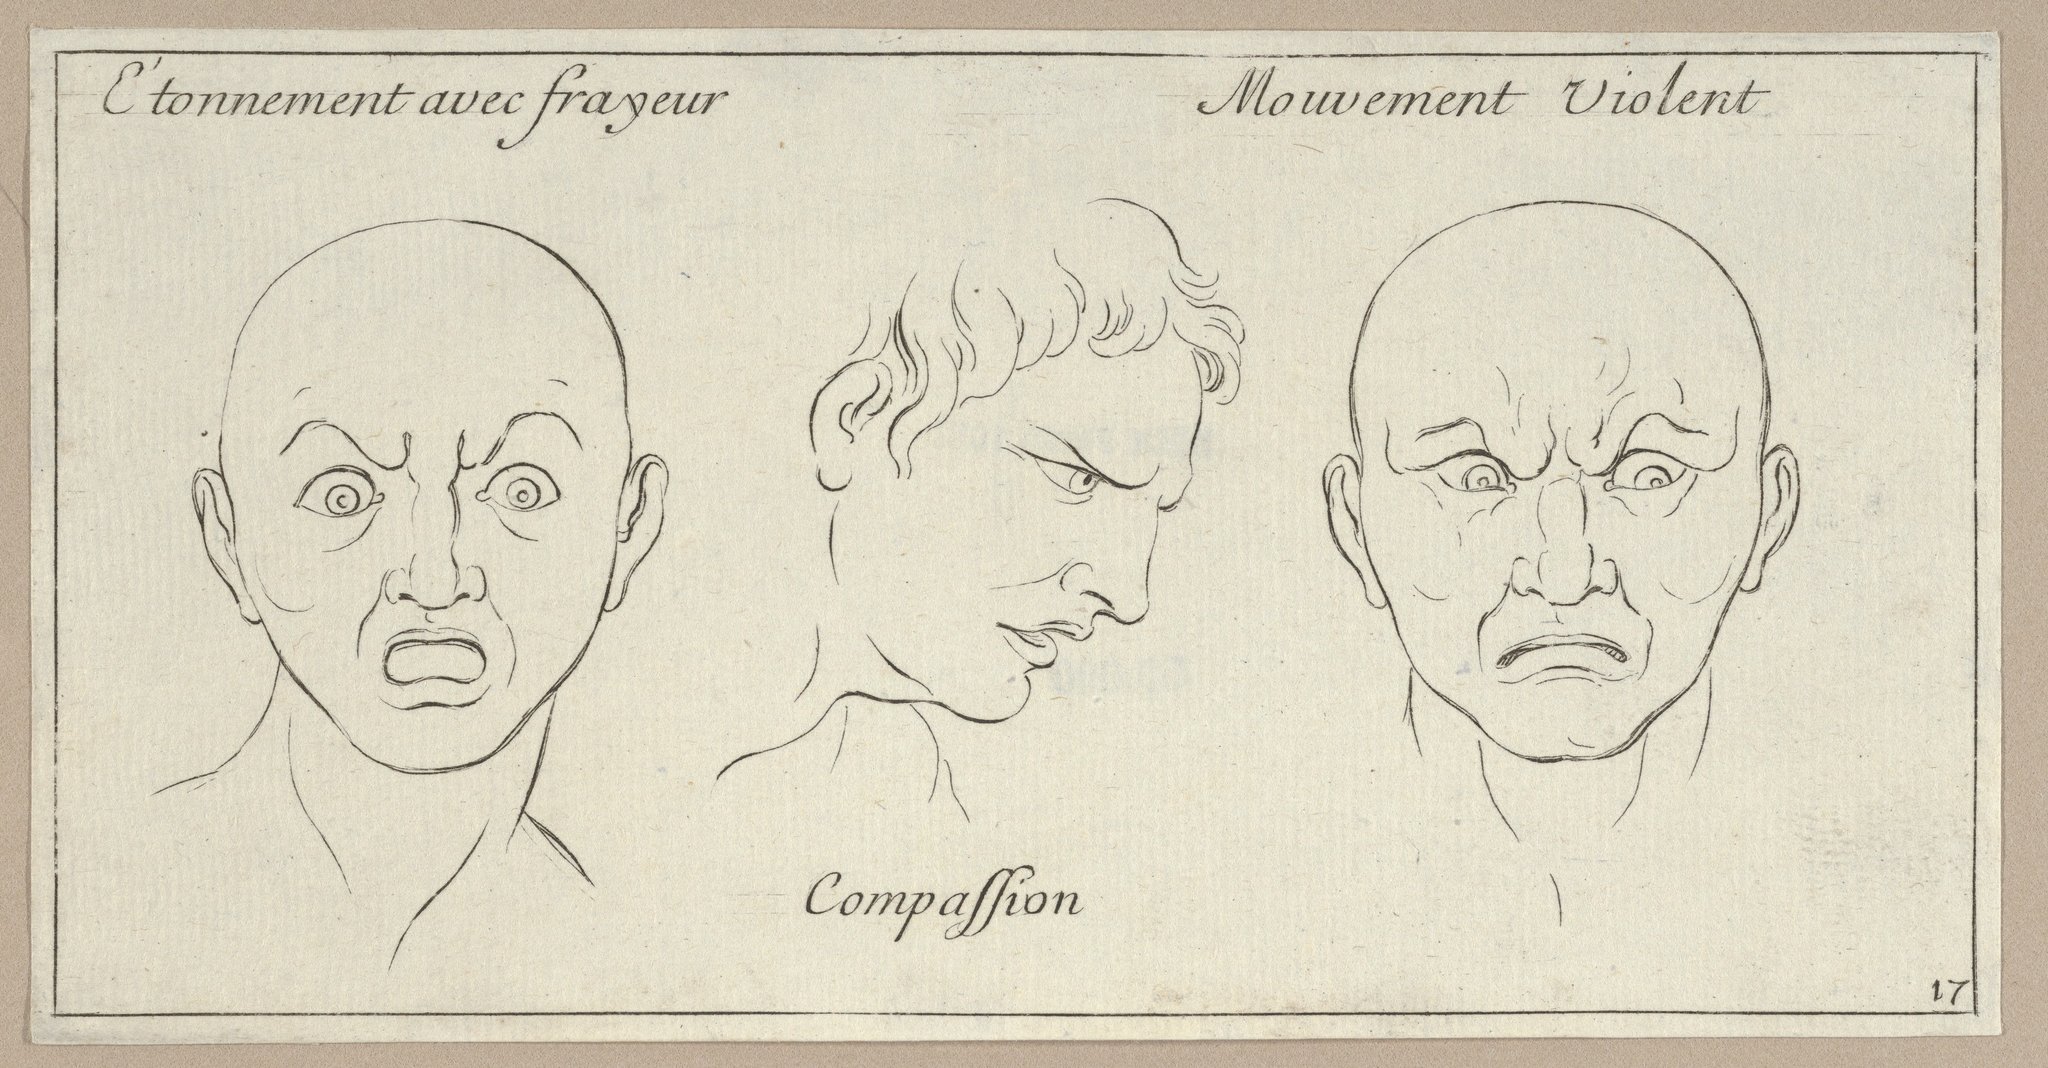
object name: print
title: Étonnement avec frayeur, Compassion, Mouvement Violent, from "Caractères des passions, gravés sur les desseins de l'illustre Monsieur le Brun"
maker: sébastien le clerc, le jeune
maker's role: etcher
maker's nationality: french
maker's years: 1676-1763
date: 1695-1720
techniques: etching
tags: heads,men